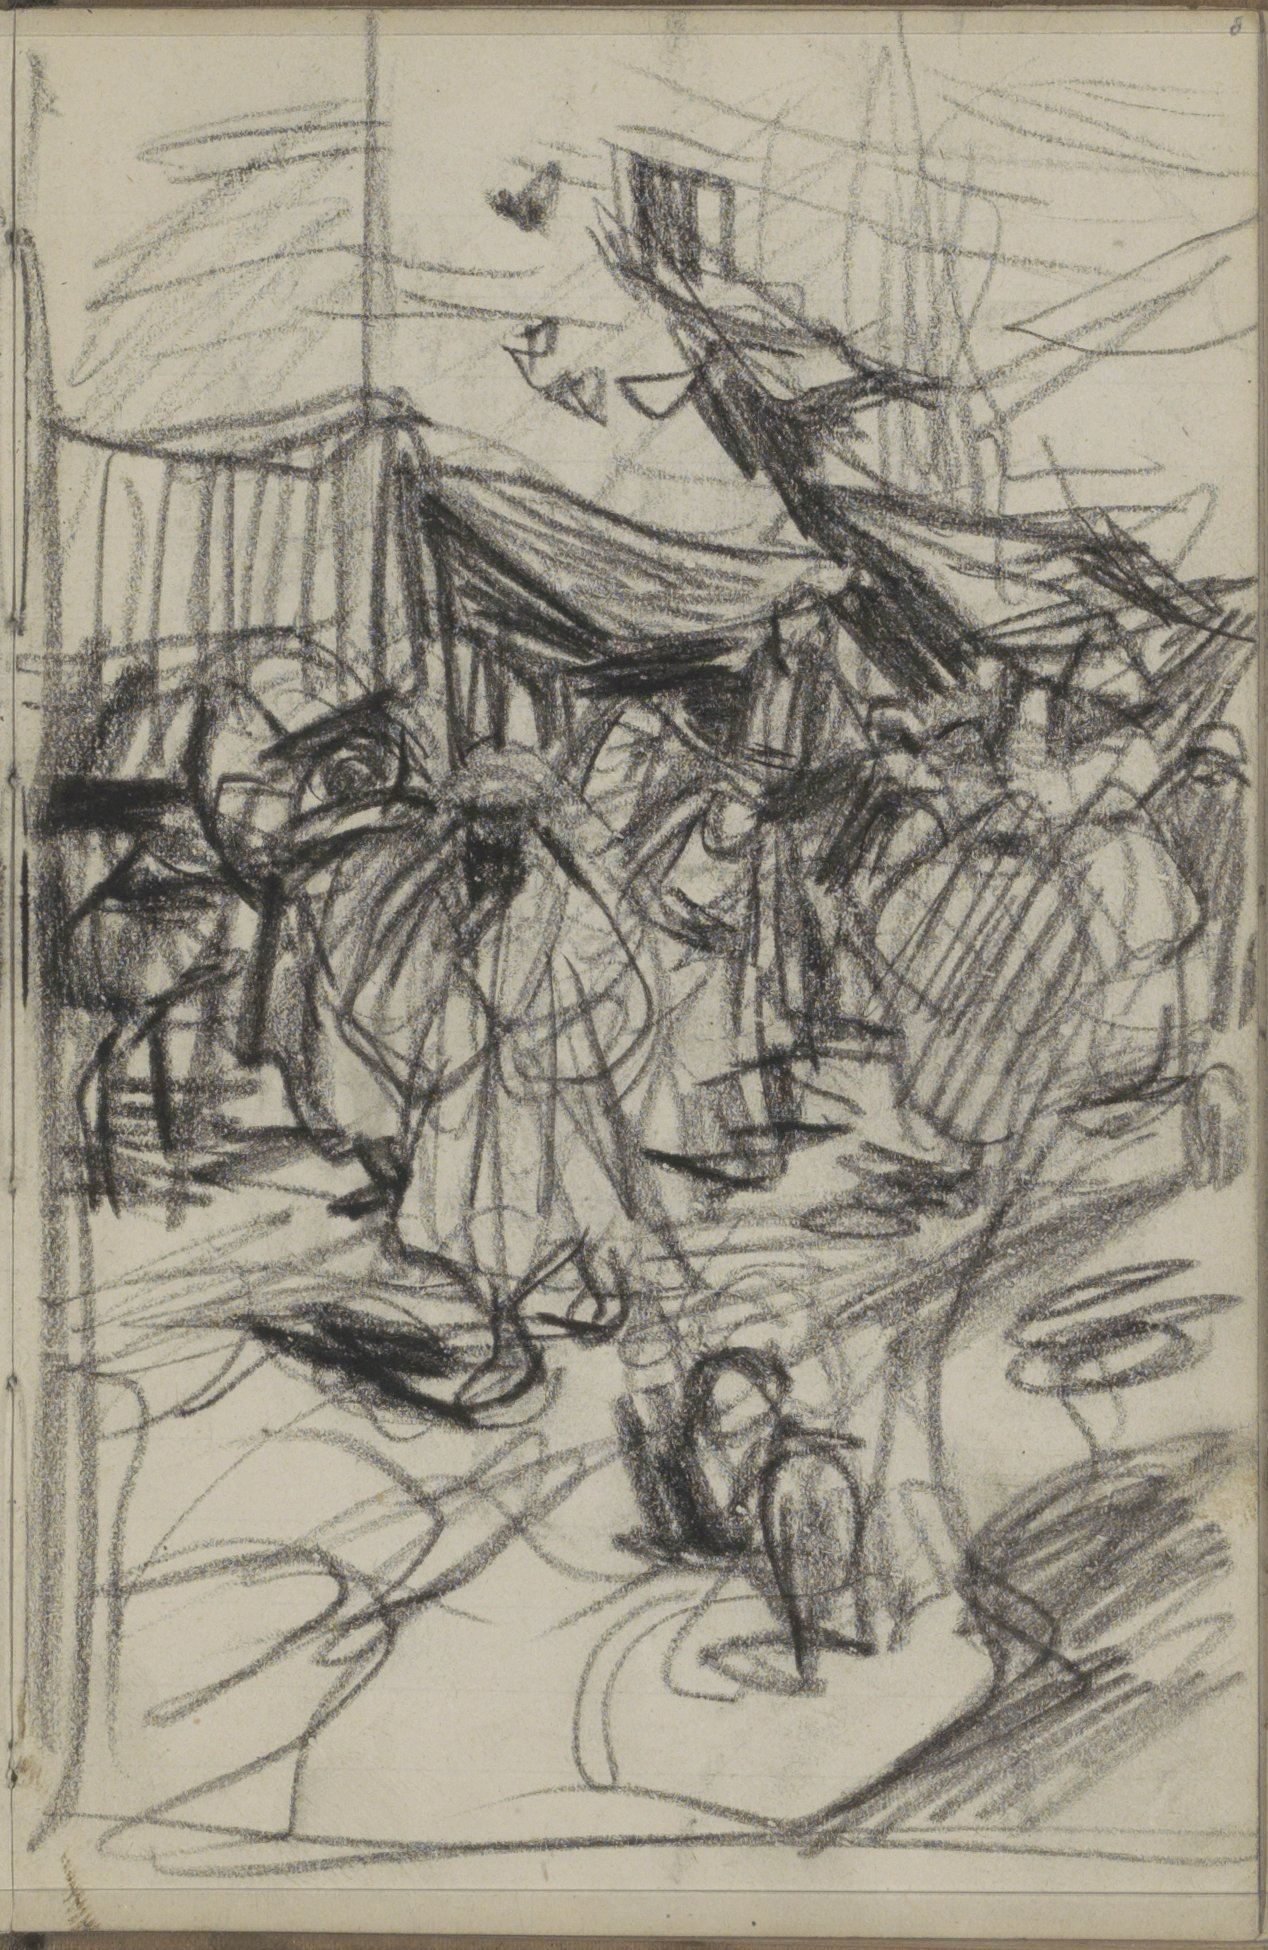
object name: sketchbook leaf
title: Figuren in oosterse kleding, mogelijk op een markt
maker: marius bauer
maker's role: draughtsman, print maker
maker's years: 1867-1932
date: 1888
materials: chalk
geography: istanbul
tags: asiatic races and peoples, market, street (+ city(-scape) with figures, staffage)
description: Pagina 8 uit een schetsboek met 56 bladen.